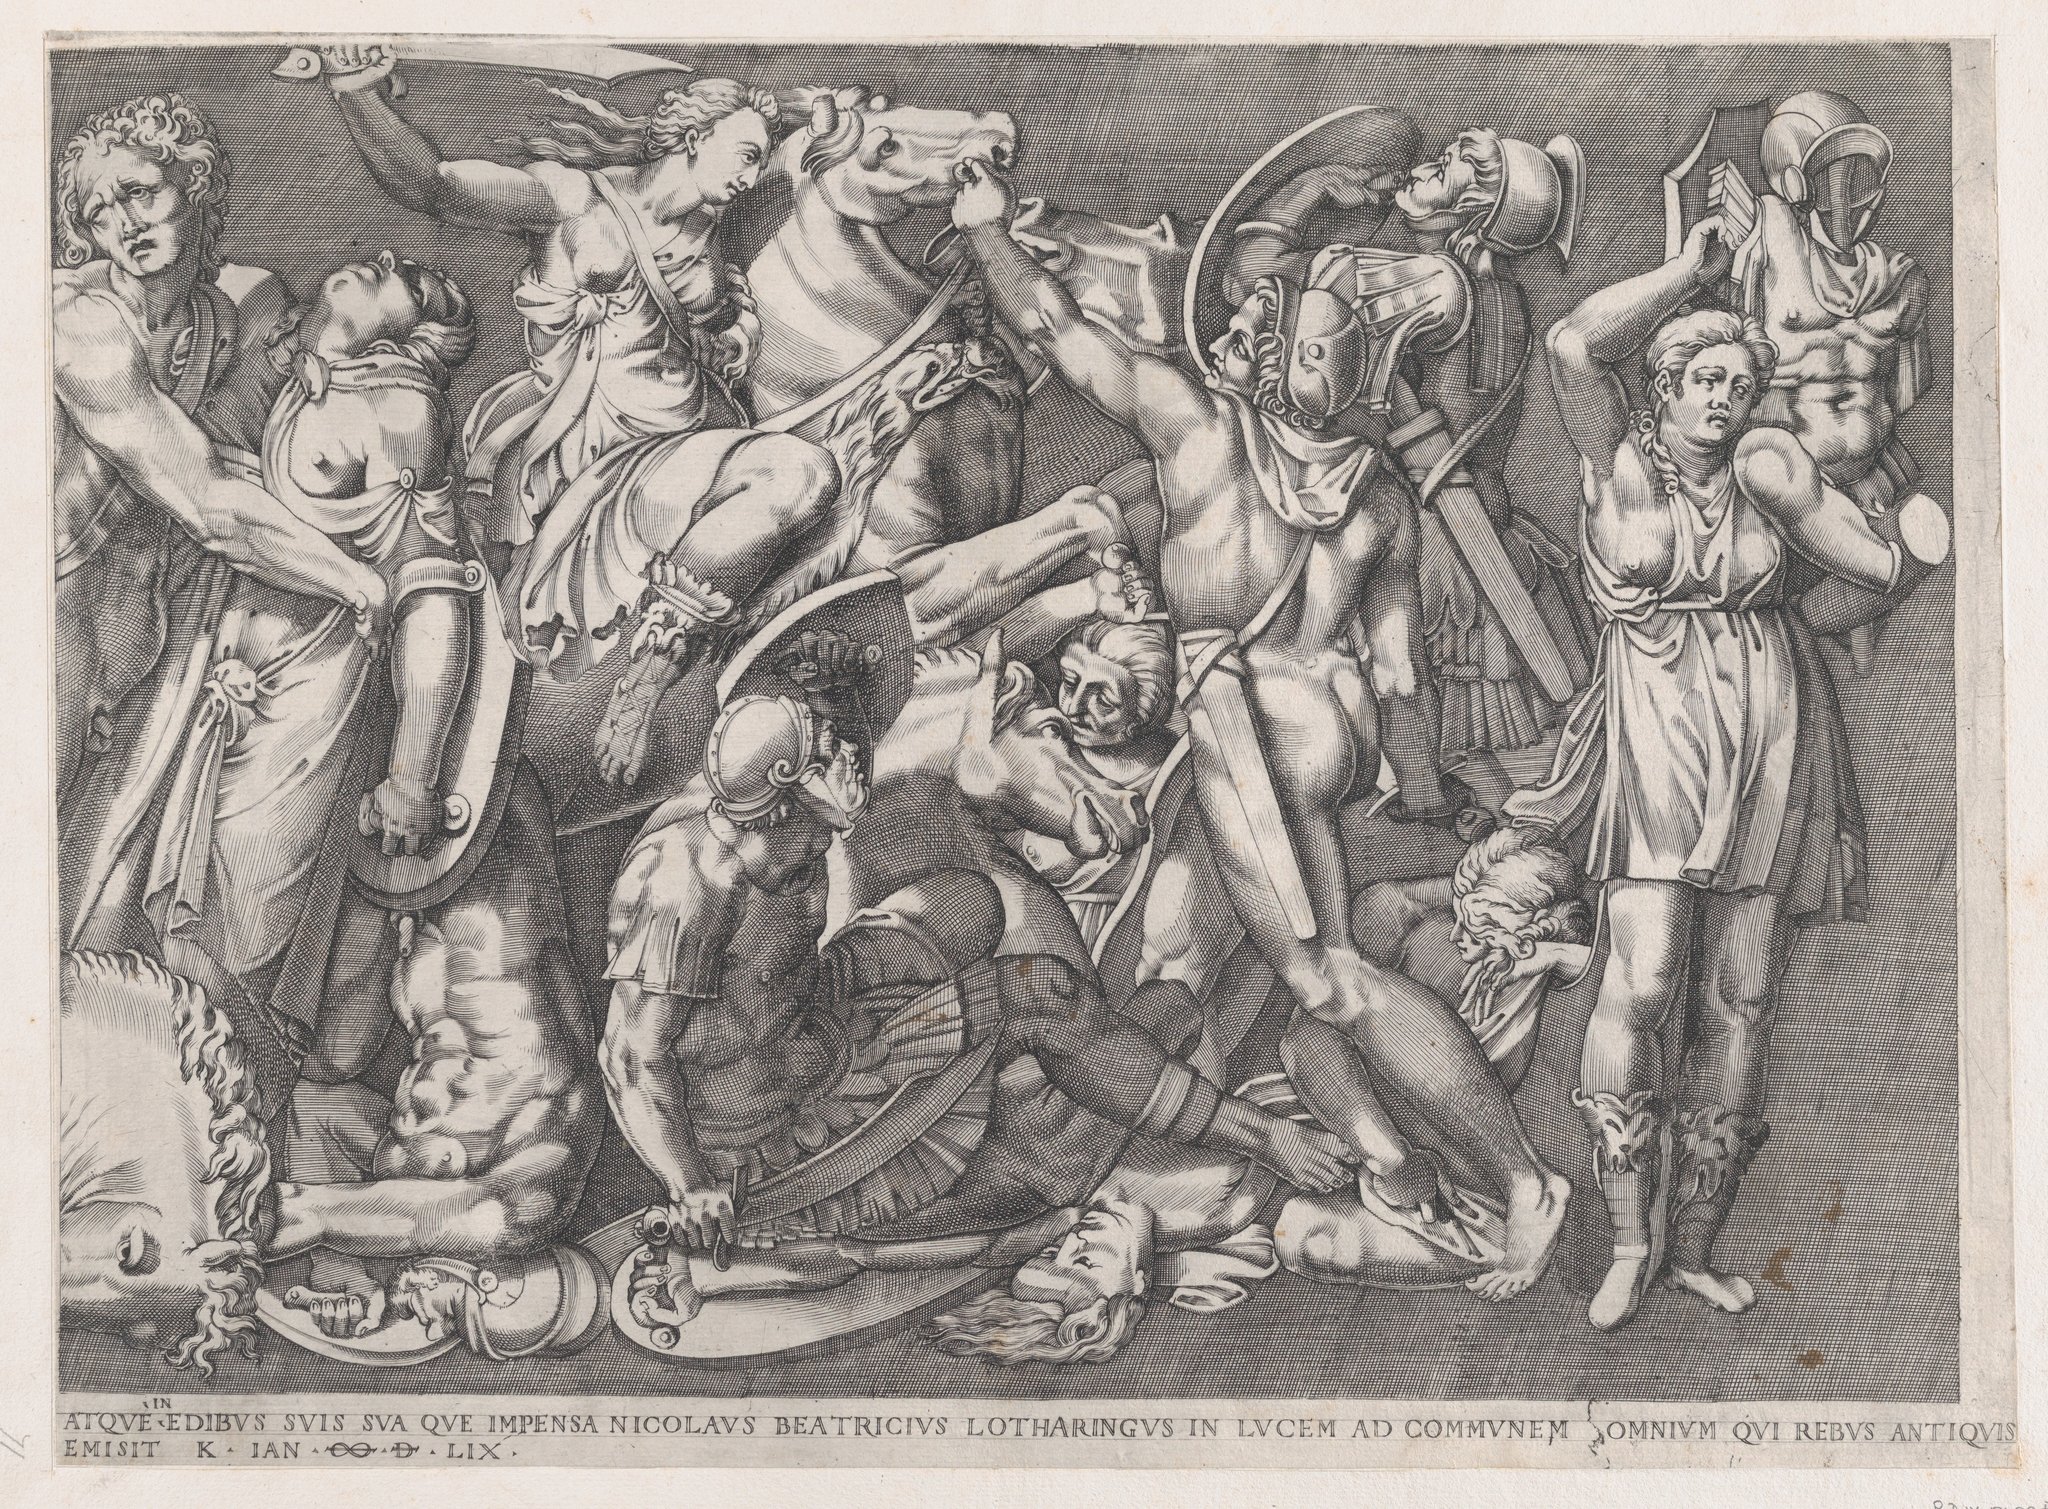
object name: print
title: Battle of the Amazons, from "Speculum Romanae Magnificentiae"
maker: nicolas beatrizet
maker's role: artist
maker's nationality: french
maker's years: 1515-1566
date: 1559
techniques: engraving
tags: battles,soldiers,men,women,horses